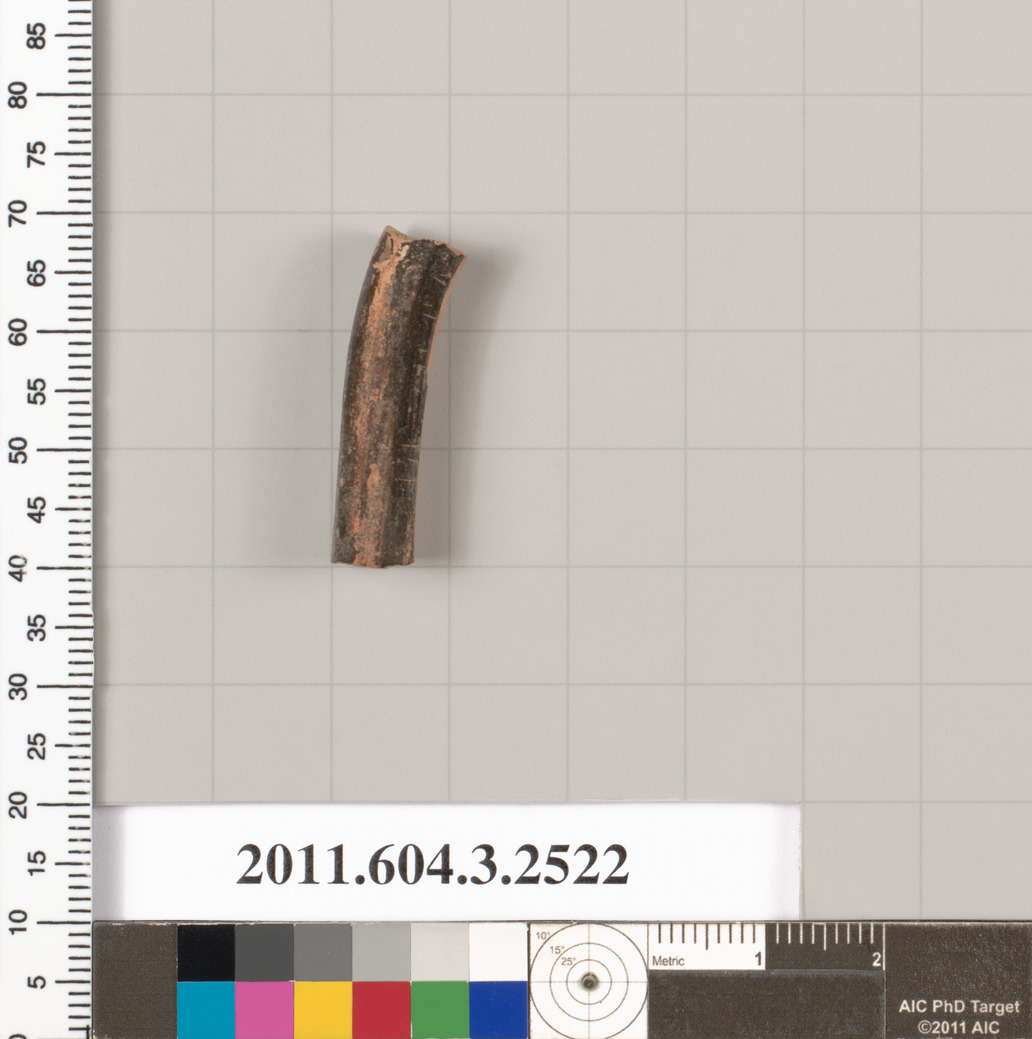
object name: kylix fragment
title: Terracotta fragment of a kylix (drinking cup)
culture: greek, attic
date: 600-401 BCE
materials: terracotta